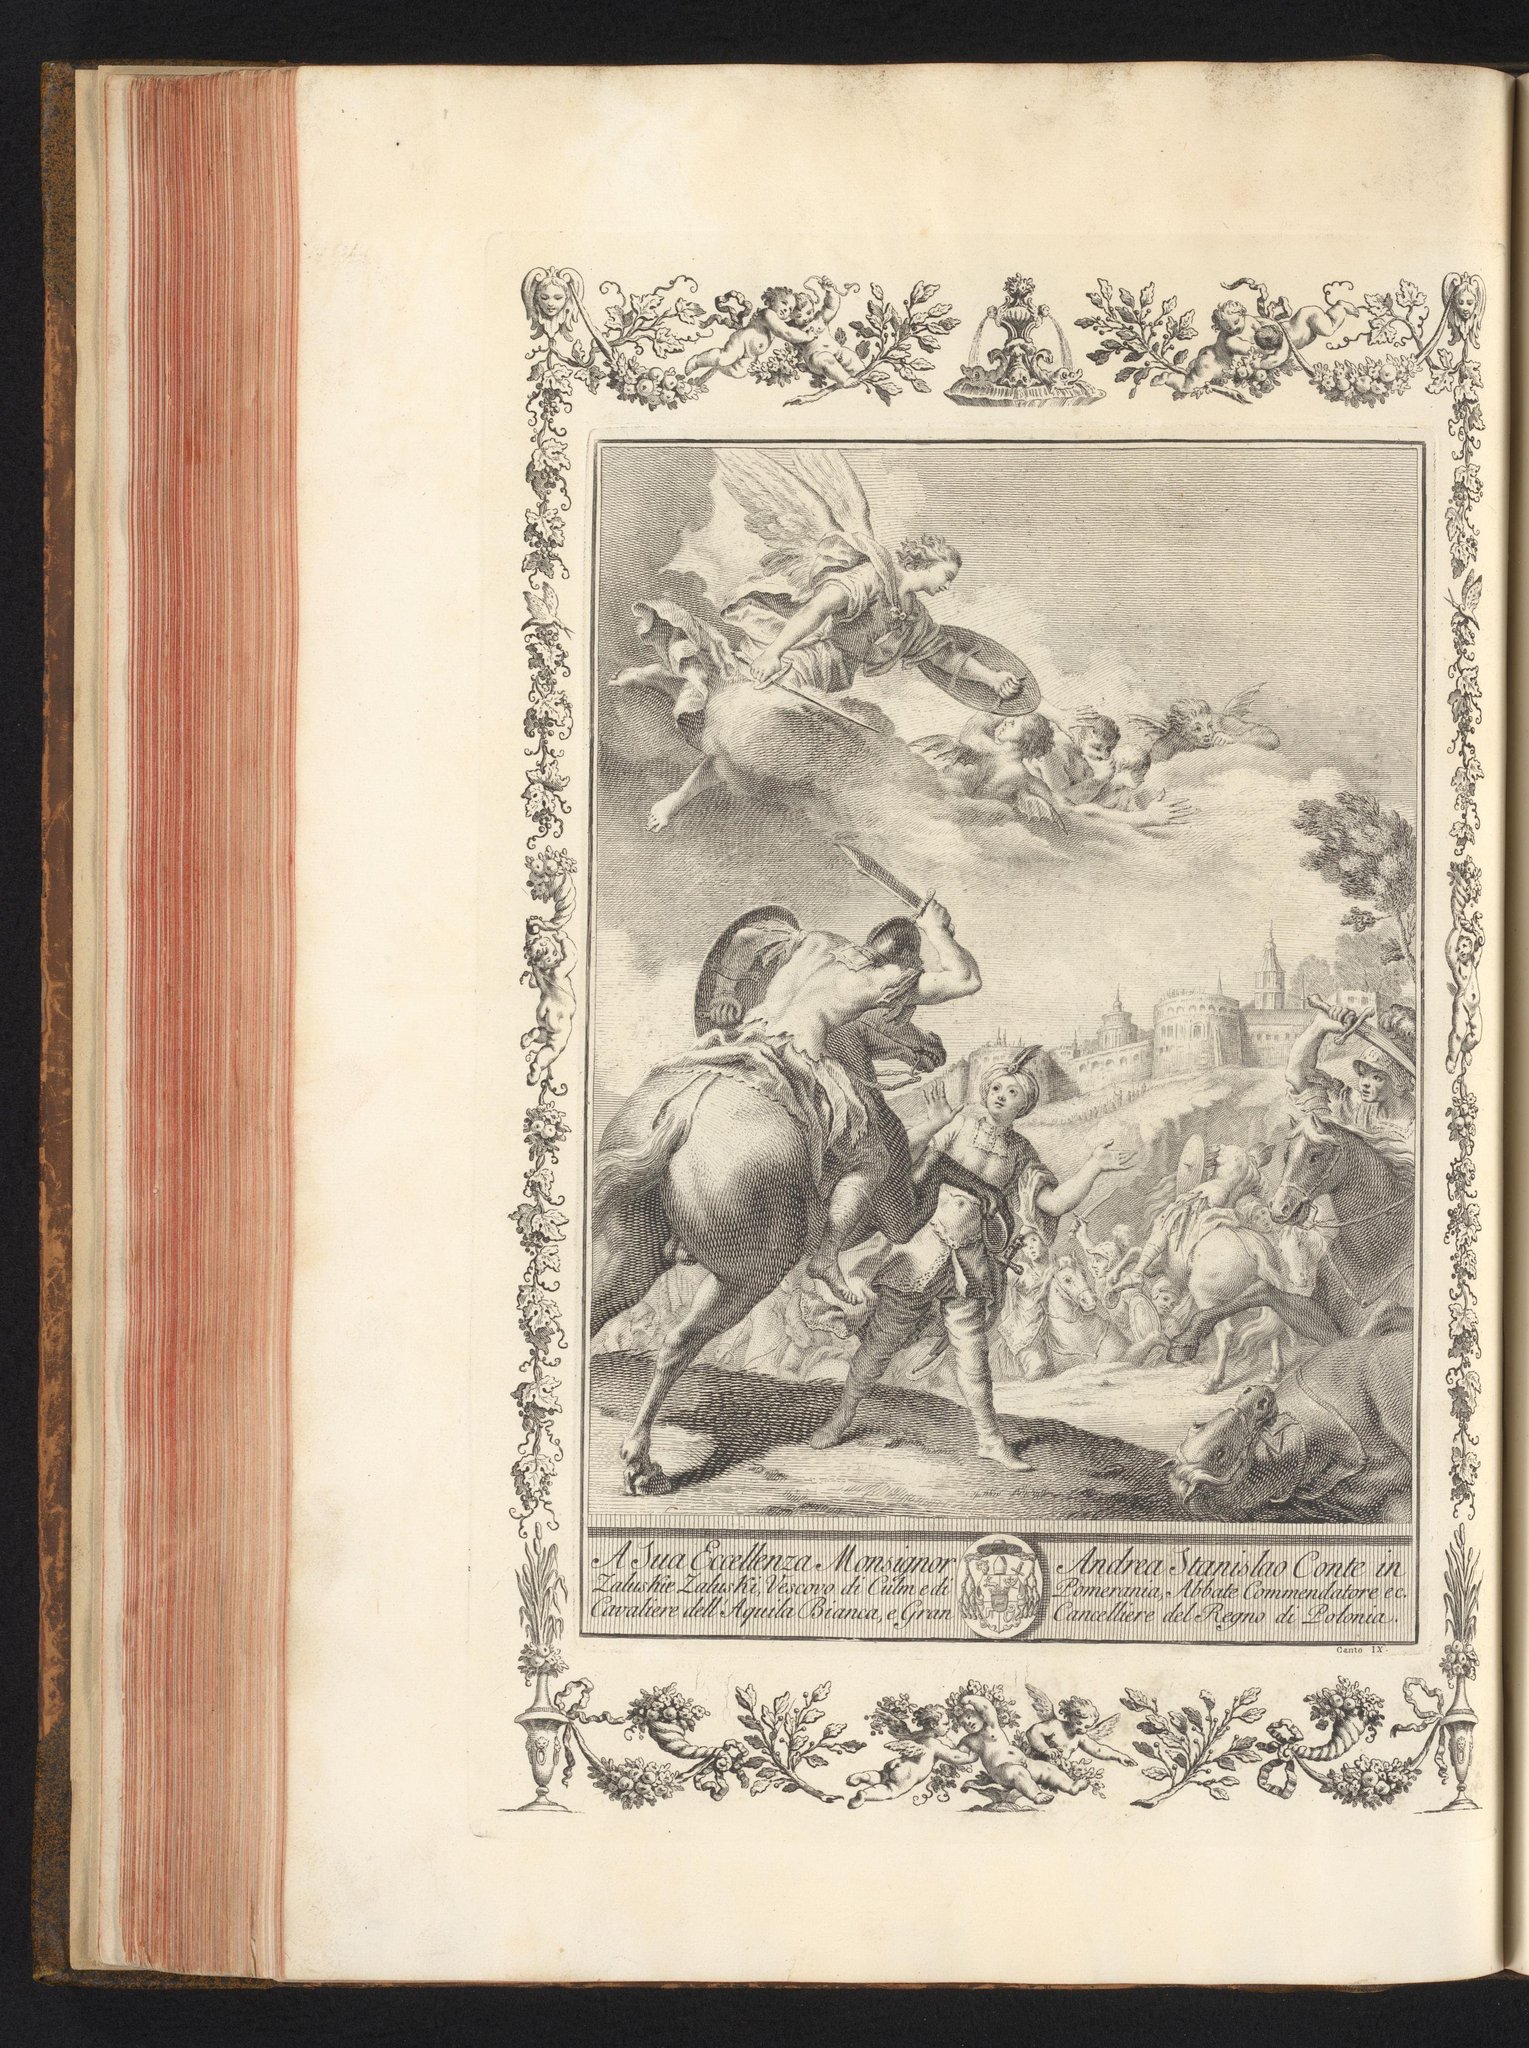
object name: book illustration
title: Canto IX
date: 1745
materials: paper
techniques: etching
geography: venice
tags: battle, city-walls, (scenes from) specific works of literature: tasso, gerusalemme liberata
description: Prent uit: Tasso, Torquato. La Gerusalemme liberata di Torquato Tasso con le figure de Giambatista Piazzetta. Venetië: Giambatista Albrizzi, 1745.